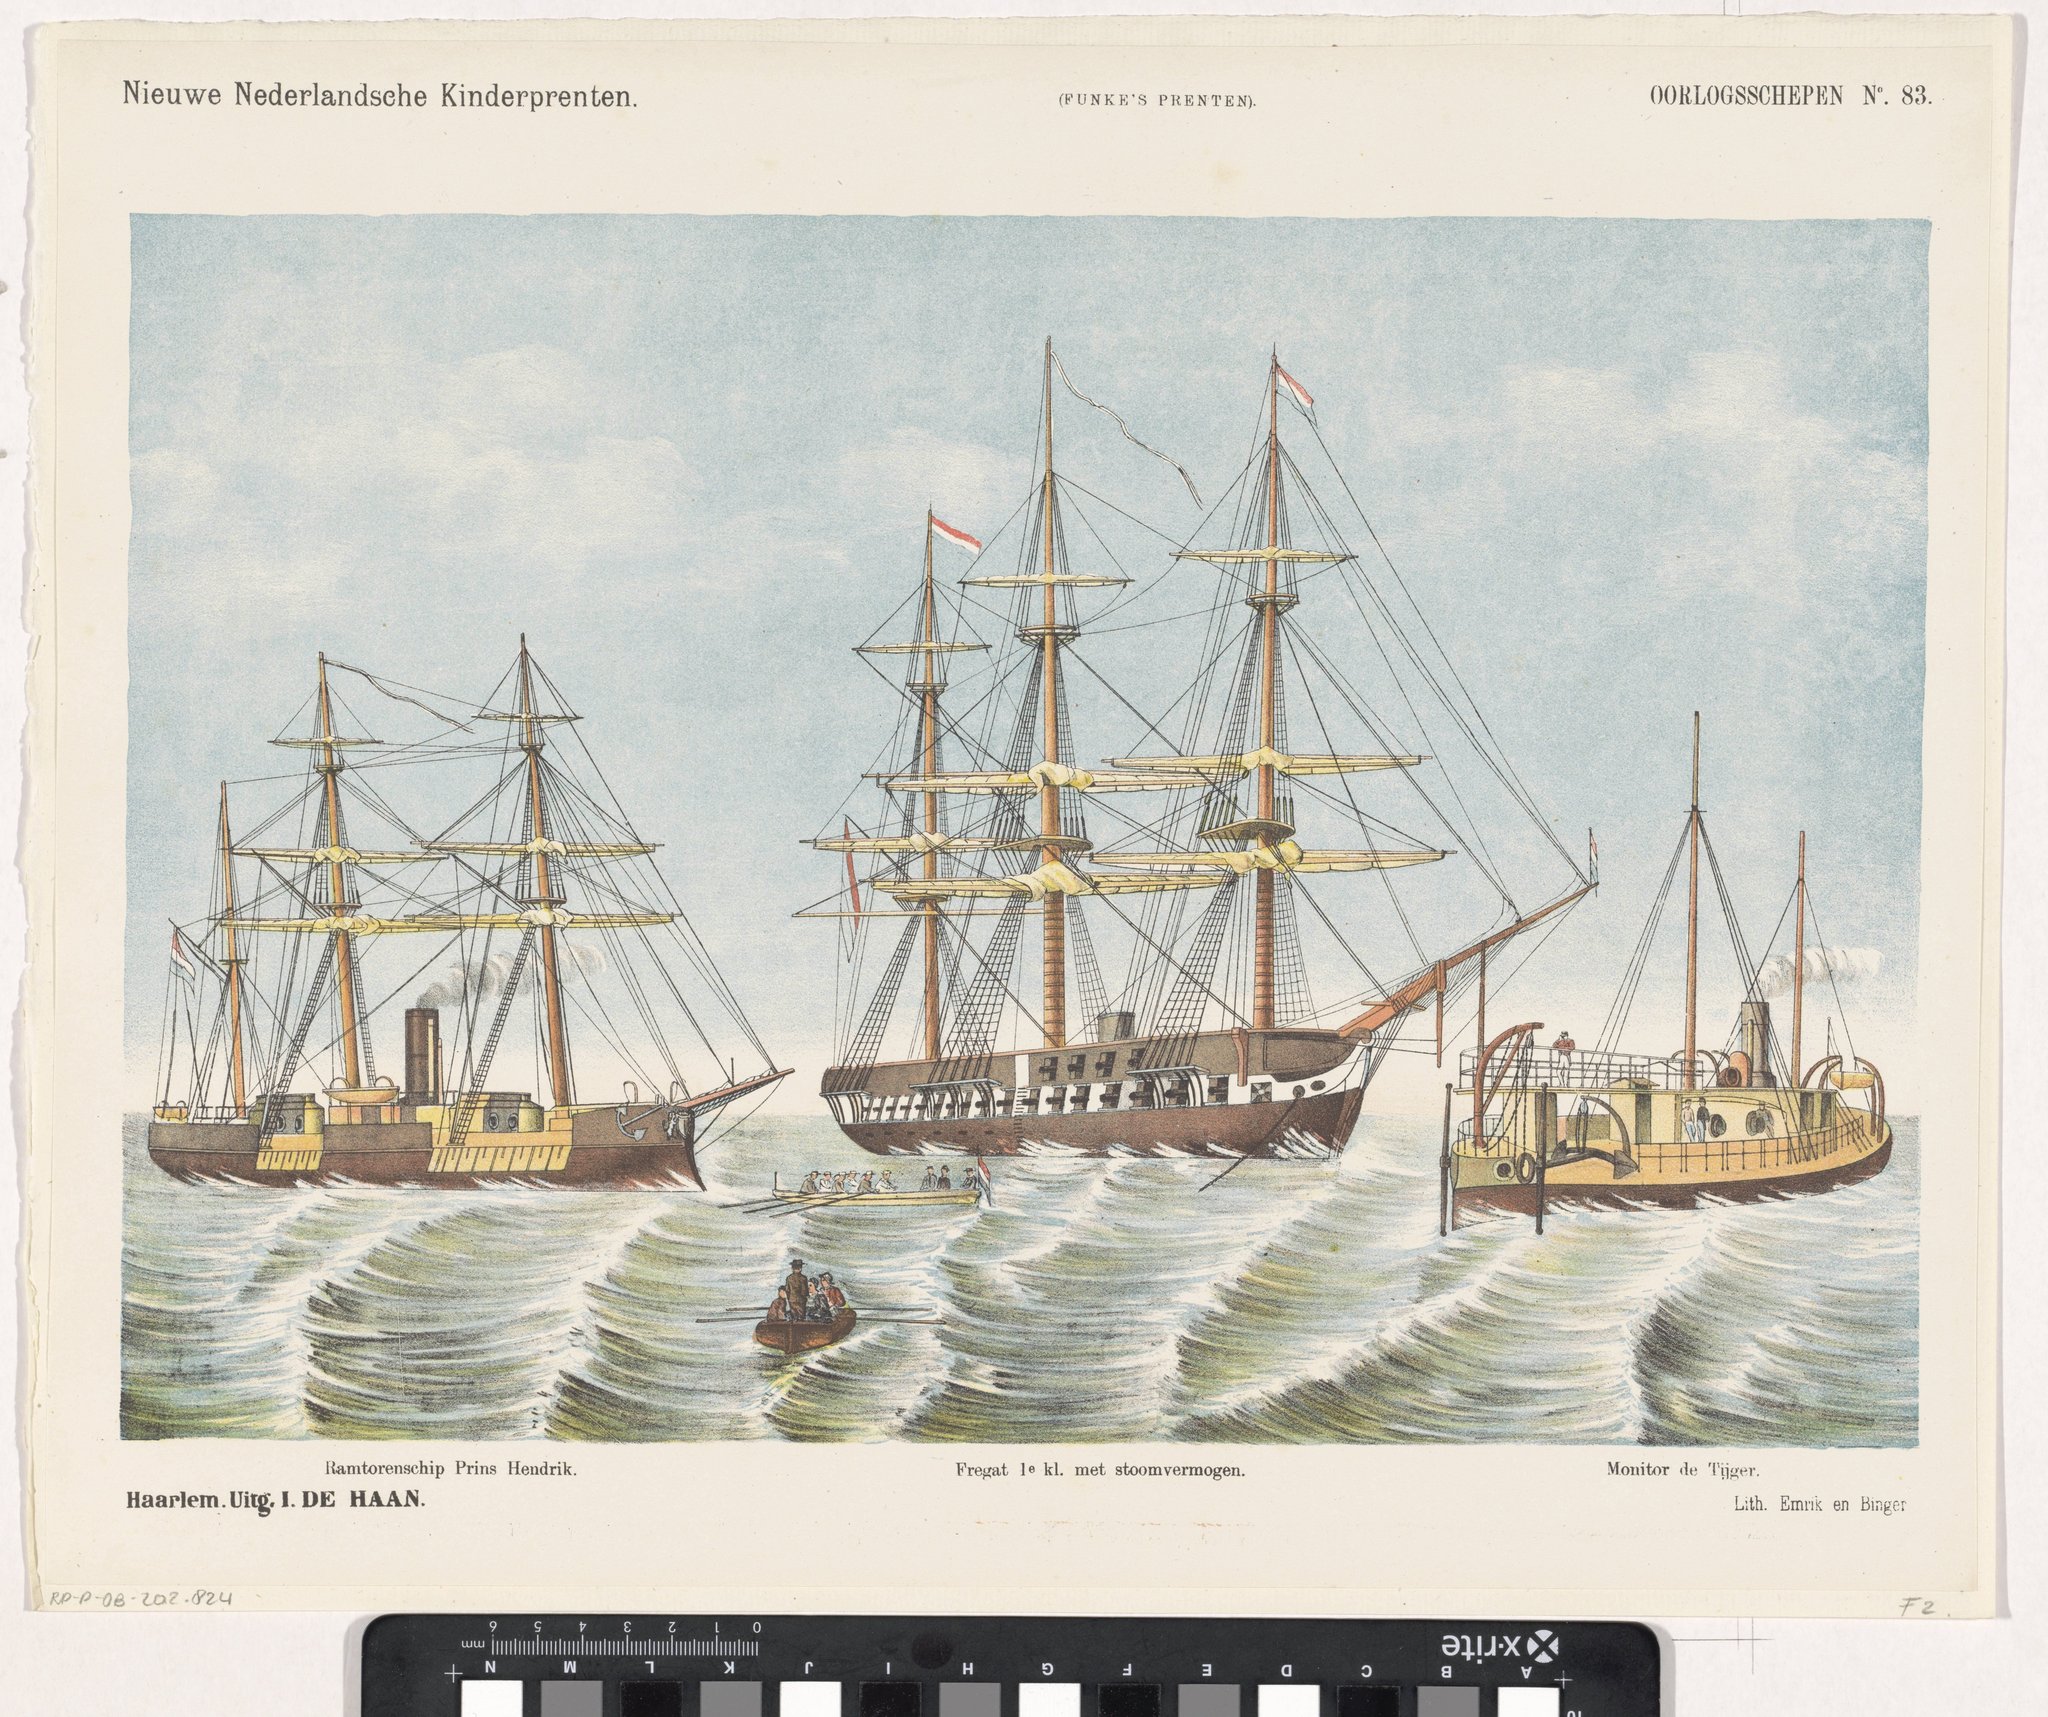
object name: print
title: Oorlogsschepen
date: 1875-1903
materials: paper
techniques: lithograph, letterpress printing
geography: haarlem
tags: military vehicles (+ sailing-ships), ships (in general)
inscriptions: collector's mark: Lugt 2760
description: Blad met een grote voorstelling van een ramtorenschip, een fregat en een monitor op zee (oorlogsschepen). Onder de voorstelling een onderschrift. Genummerd rechtsboven: No. 83.